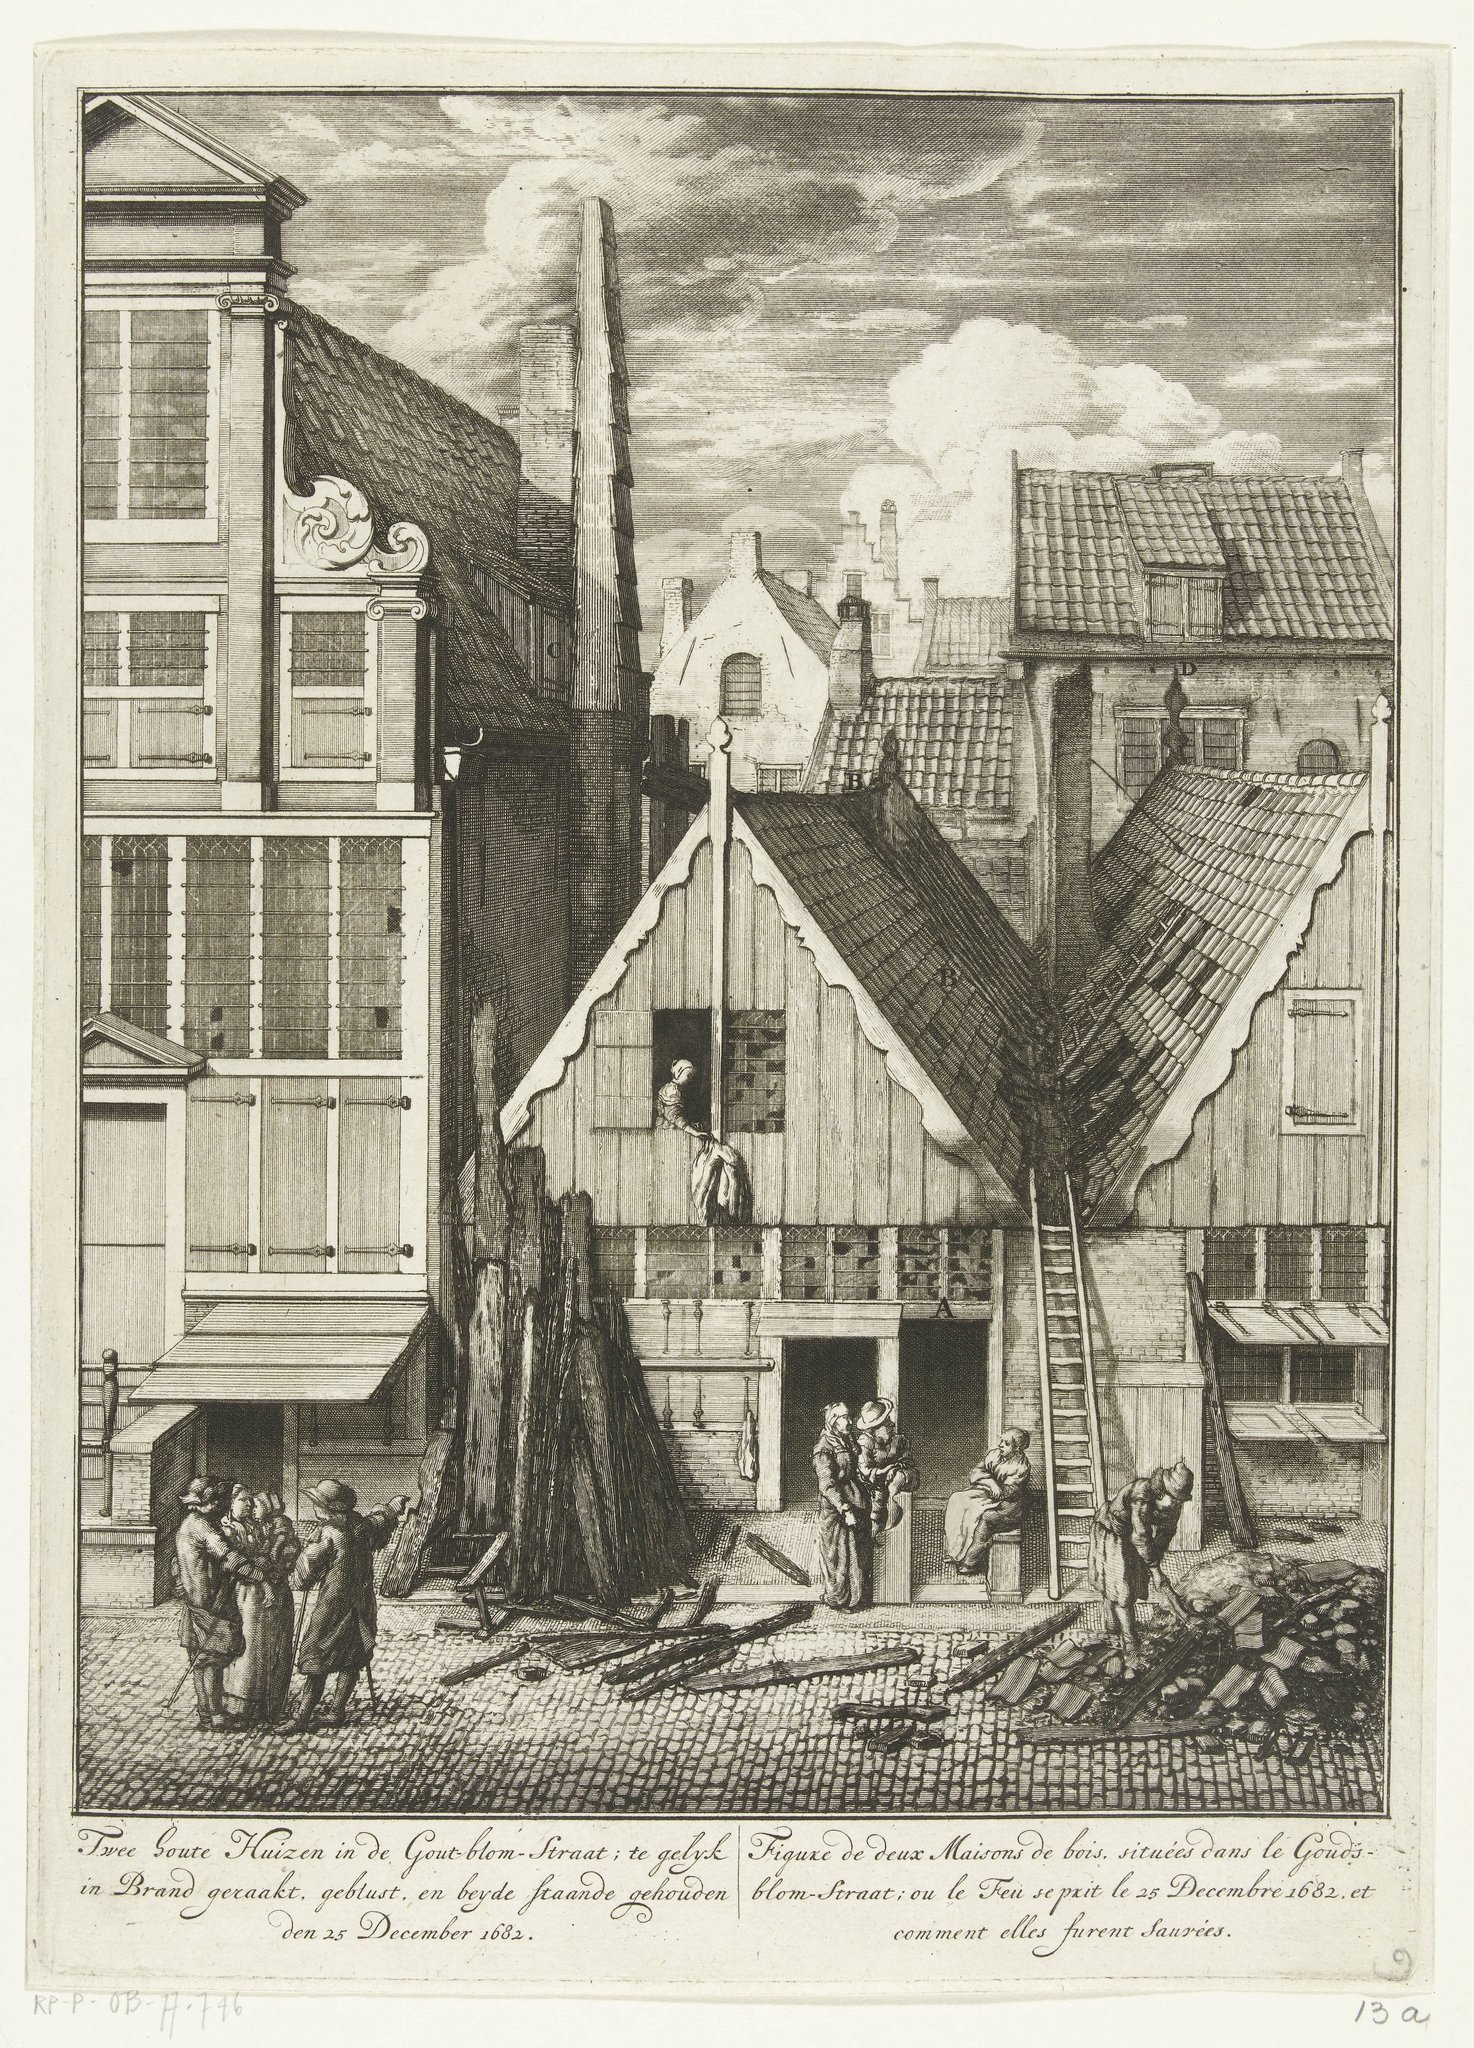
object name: book illustration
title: Twee houte huizen in de Gout-blom-Straat; te gelyk in brand geraakt, geblust, en beyde staande gehouden den 25 december 1682 / Figure de deux maisons de bois, situées dans le Gouds-blom-Straat; ou le feu se prit le 25 decembre 1682, et comment elles furent sauvées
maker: jan van der heyden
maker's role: draughtsman, painter, print maker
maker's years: 1637-1712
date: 1690-1735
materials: paper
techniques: engraving, etching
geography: amsterdam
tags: amsterdam, painter, print maker, draughtsman, jan van der heyden, urban housing, ruin of a building ~ architecture, fire-fighting, fire-extinguishing equipment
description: Prent ook gebruikt in: Heyden, Jan van der. Beschryving der nieuwlyks uitgevonden en geoctrojeerde slang-brand-spuiten en haare wyze van brand-blussen, tegenwoordig binnen Amsterdam in gebruik zijnde (…). 1e druk. Amsterdam: Jan Rieuwertsz. (II), 1690. En in: Heyden, Jan van der. Beschryving der nieuwlyks uitgevonden en geoctrojeerde slang-brand-spuiten en haare wyze van brand-blussen, tegenwoordig binnen Amsterdam in gebruik zijnde (…). 2e druk. Amsterdam: erfgenamen Jan van der Heyden, 1735. Voor tegendruk zie RP-P-OB-55.390.